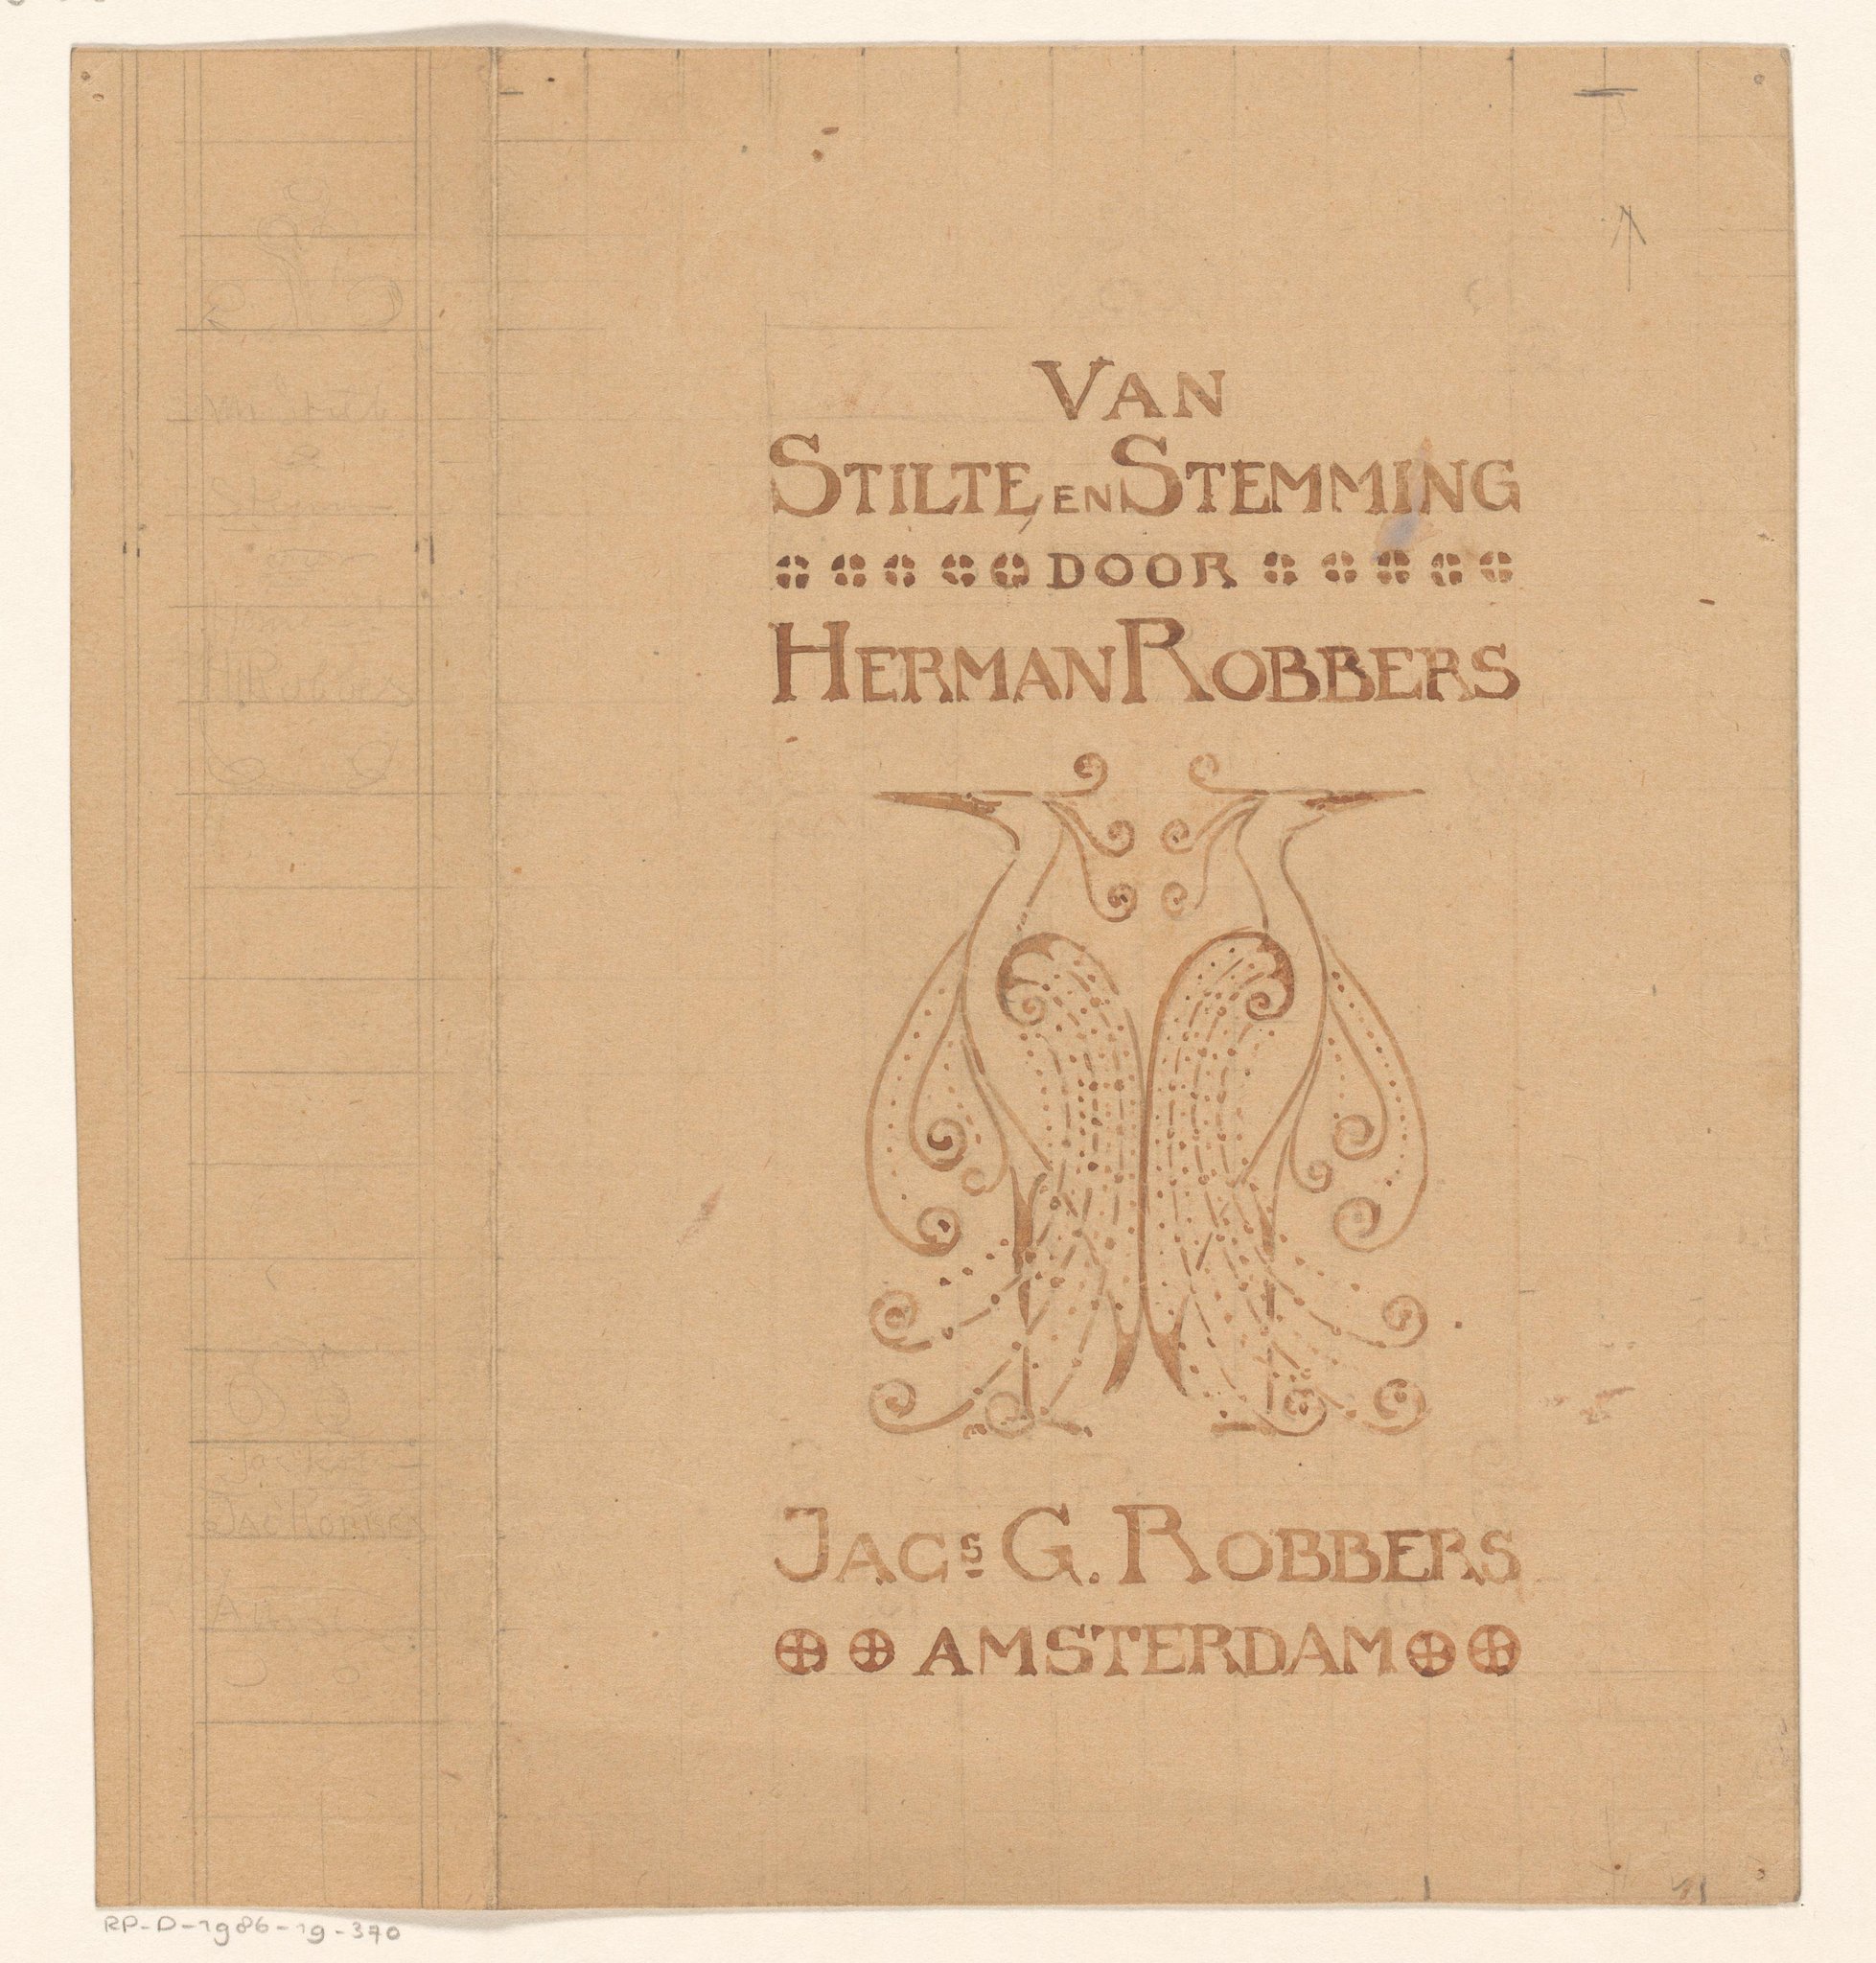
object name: study for binding design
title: Bandontwerp voor: Herman Robbers, Van stilte en stemming, 1905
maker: reinier willem petrus de vries (1874-1953)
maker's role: draughtsman, print maker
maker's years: 1874-1953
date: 1905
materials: ink, paper, pencil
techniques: brush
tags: fabulous animals ~ ornamental birds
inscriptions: collector's mark: ‘R:MVS.’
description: Bandontwerp voor: Robbers, Herman. Van stilte en stemming. Amsterdam: Robbers, 1905.